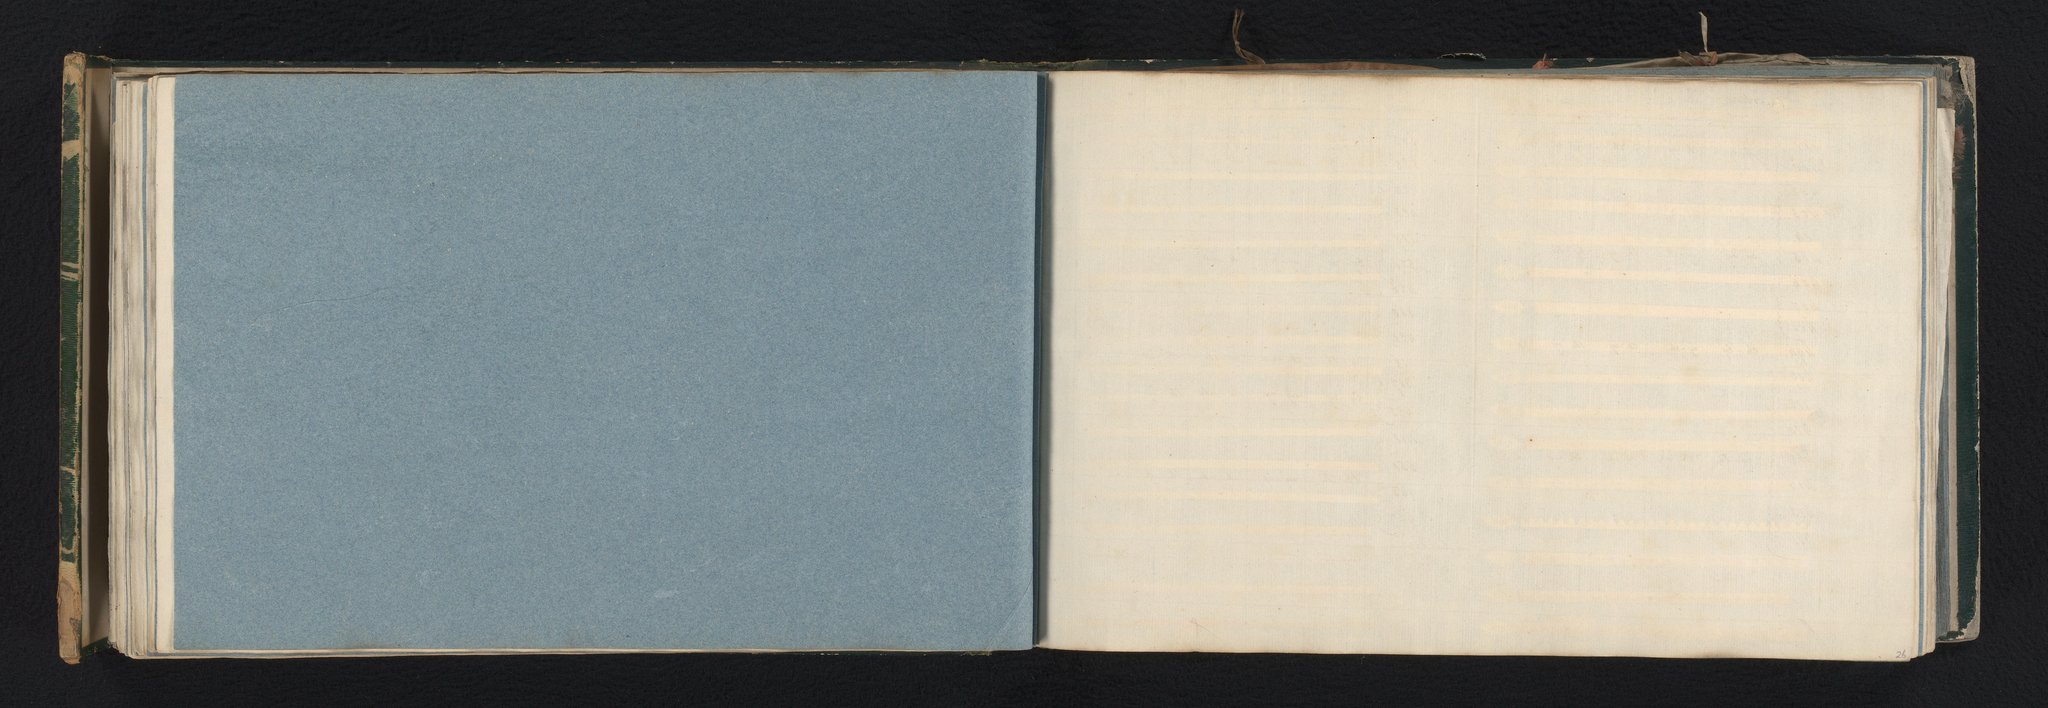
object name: album leaf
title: Twee lege bladzijden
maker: Anonymous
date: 1830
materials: paper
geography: france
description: Twee lege bladzijden. Onderdeel van het stalenboek geschonken door de dames Van Rijn, vermoedelijk van een Franse papierfabrikant van luxe papieren, of diens vertegenwoordiger in Nederland, ca. 1830.